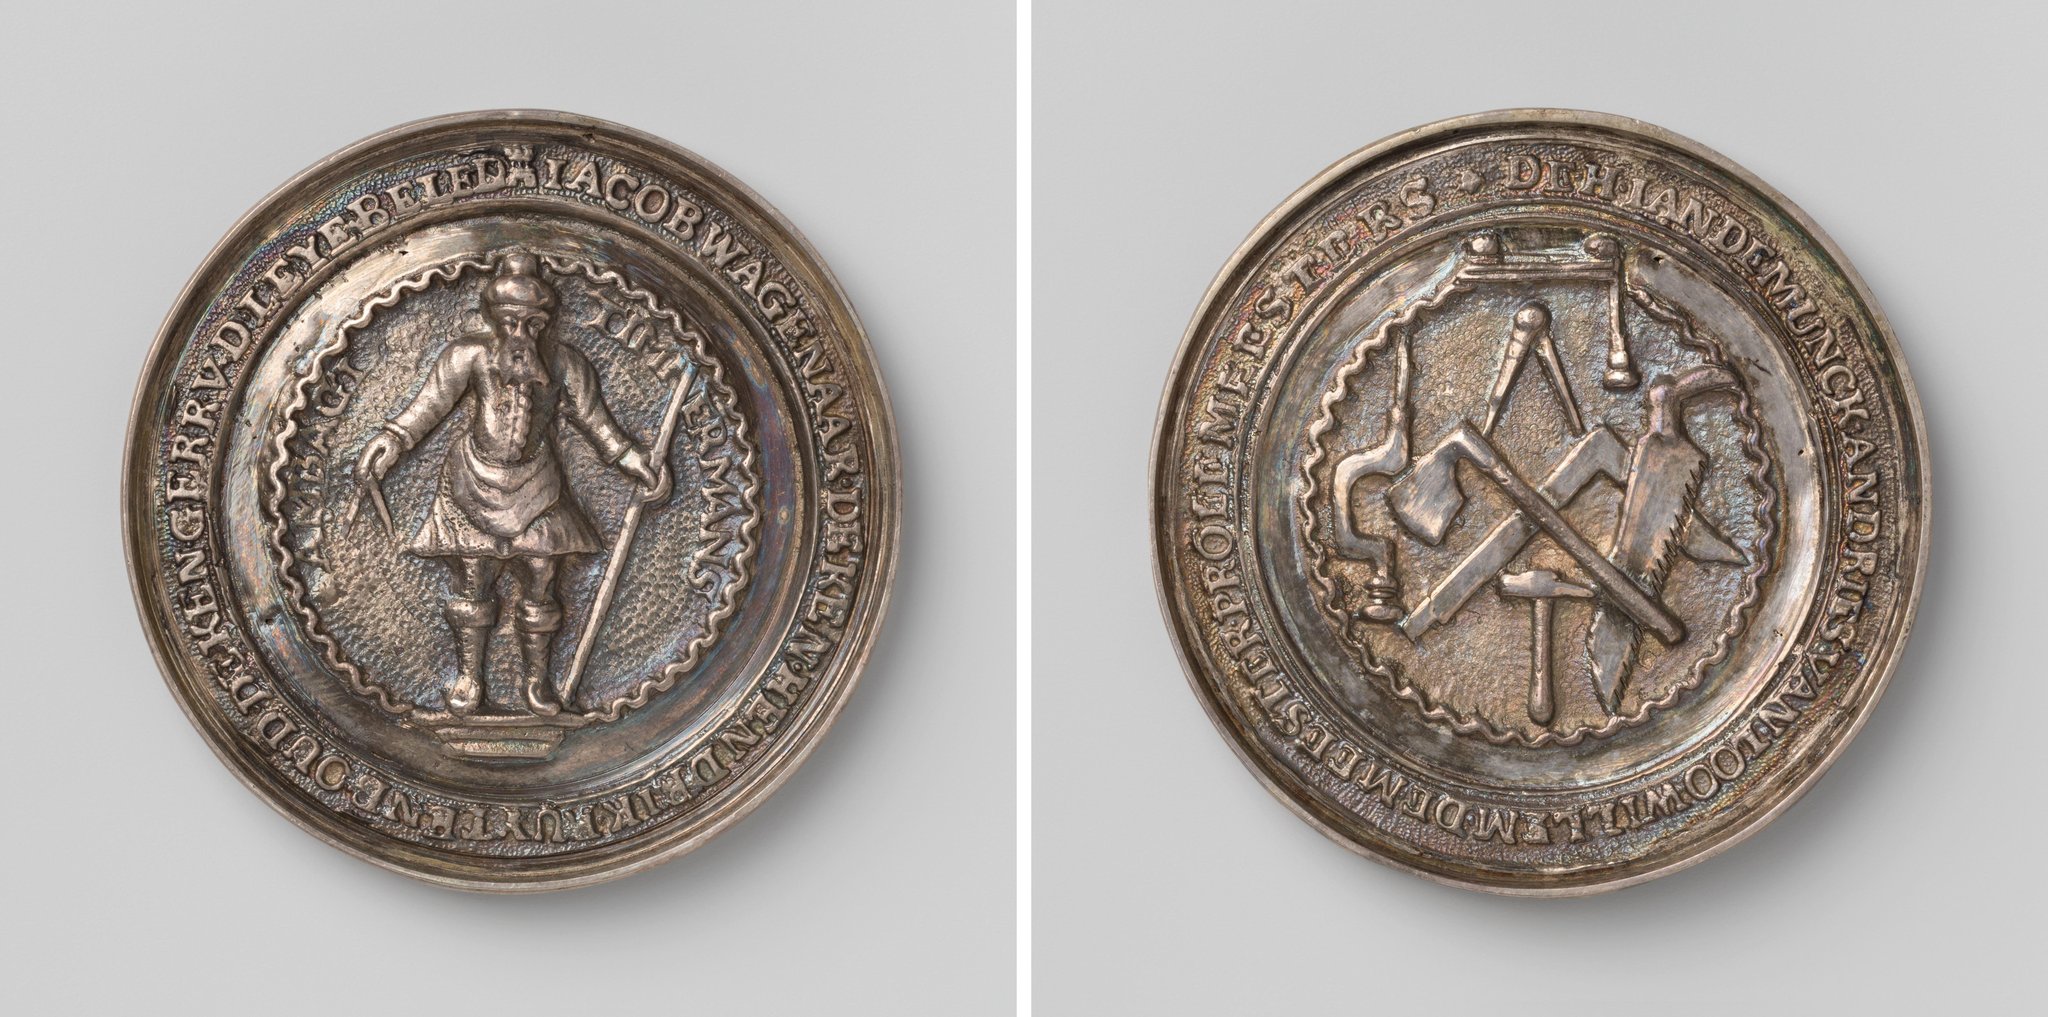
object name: overmanspenning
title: Timmerliedengilde van Middelburg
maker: Anonymous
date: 1763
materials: silver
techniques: casting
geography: middelburg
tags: middelburg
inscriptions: circumscription: ‘(toren) IACOB WAGENAAR . DEKEN . HENDRIK . RUYTENBOUD . DEKEN . GERR . V . D . LEYE BELED / TIMMERMANS - AMBAGT’, circumscription: ‘(teken) DE . H . IAN . DE MUNCK . ANDRIES . VAN . LOO . WILLEM . DE . MEESTER . PROEFMEESTERS’, edge inscription: ‘MR . - ANTHONY . HUYSMAN . SCHEPEN EN RAAD OVERDEKEN . VAN HET . HUYS TIMMERMANS . AMBACHT . 1763 .’